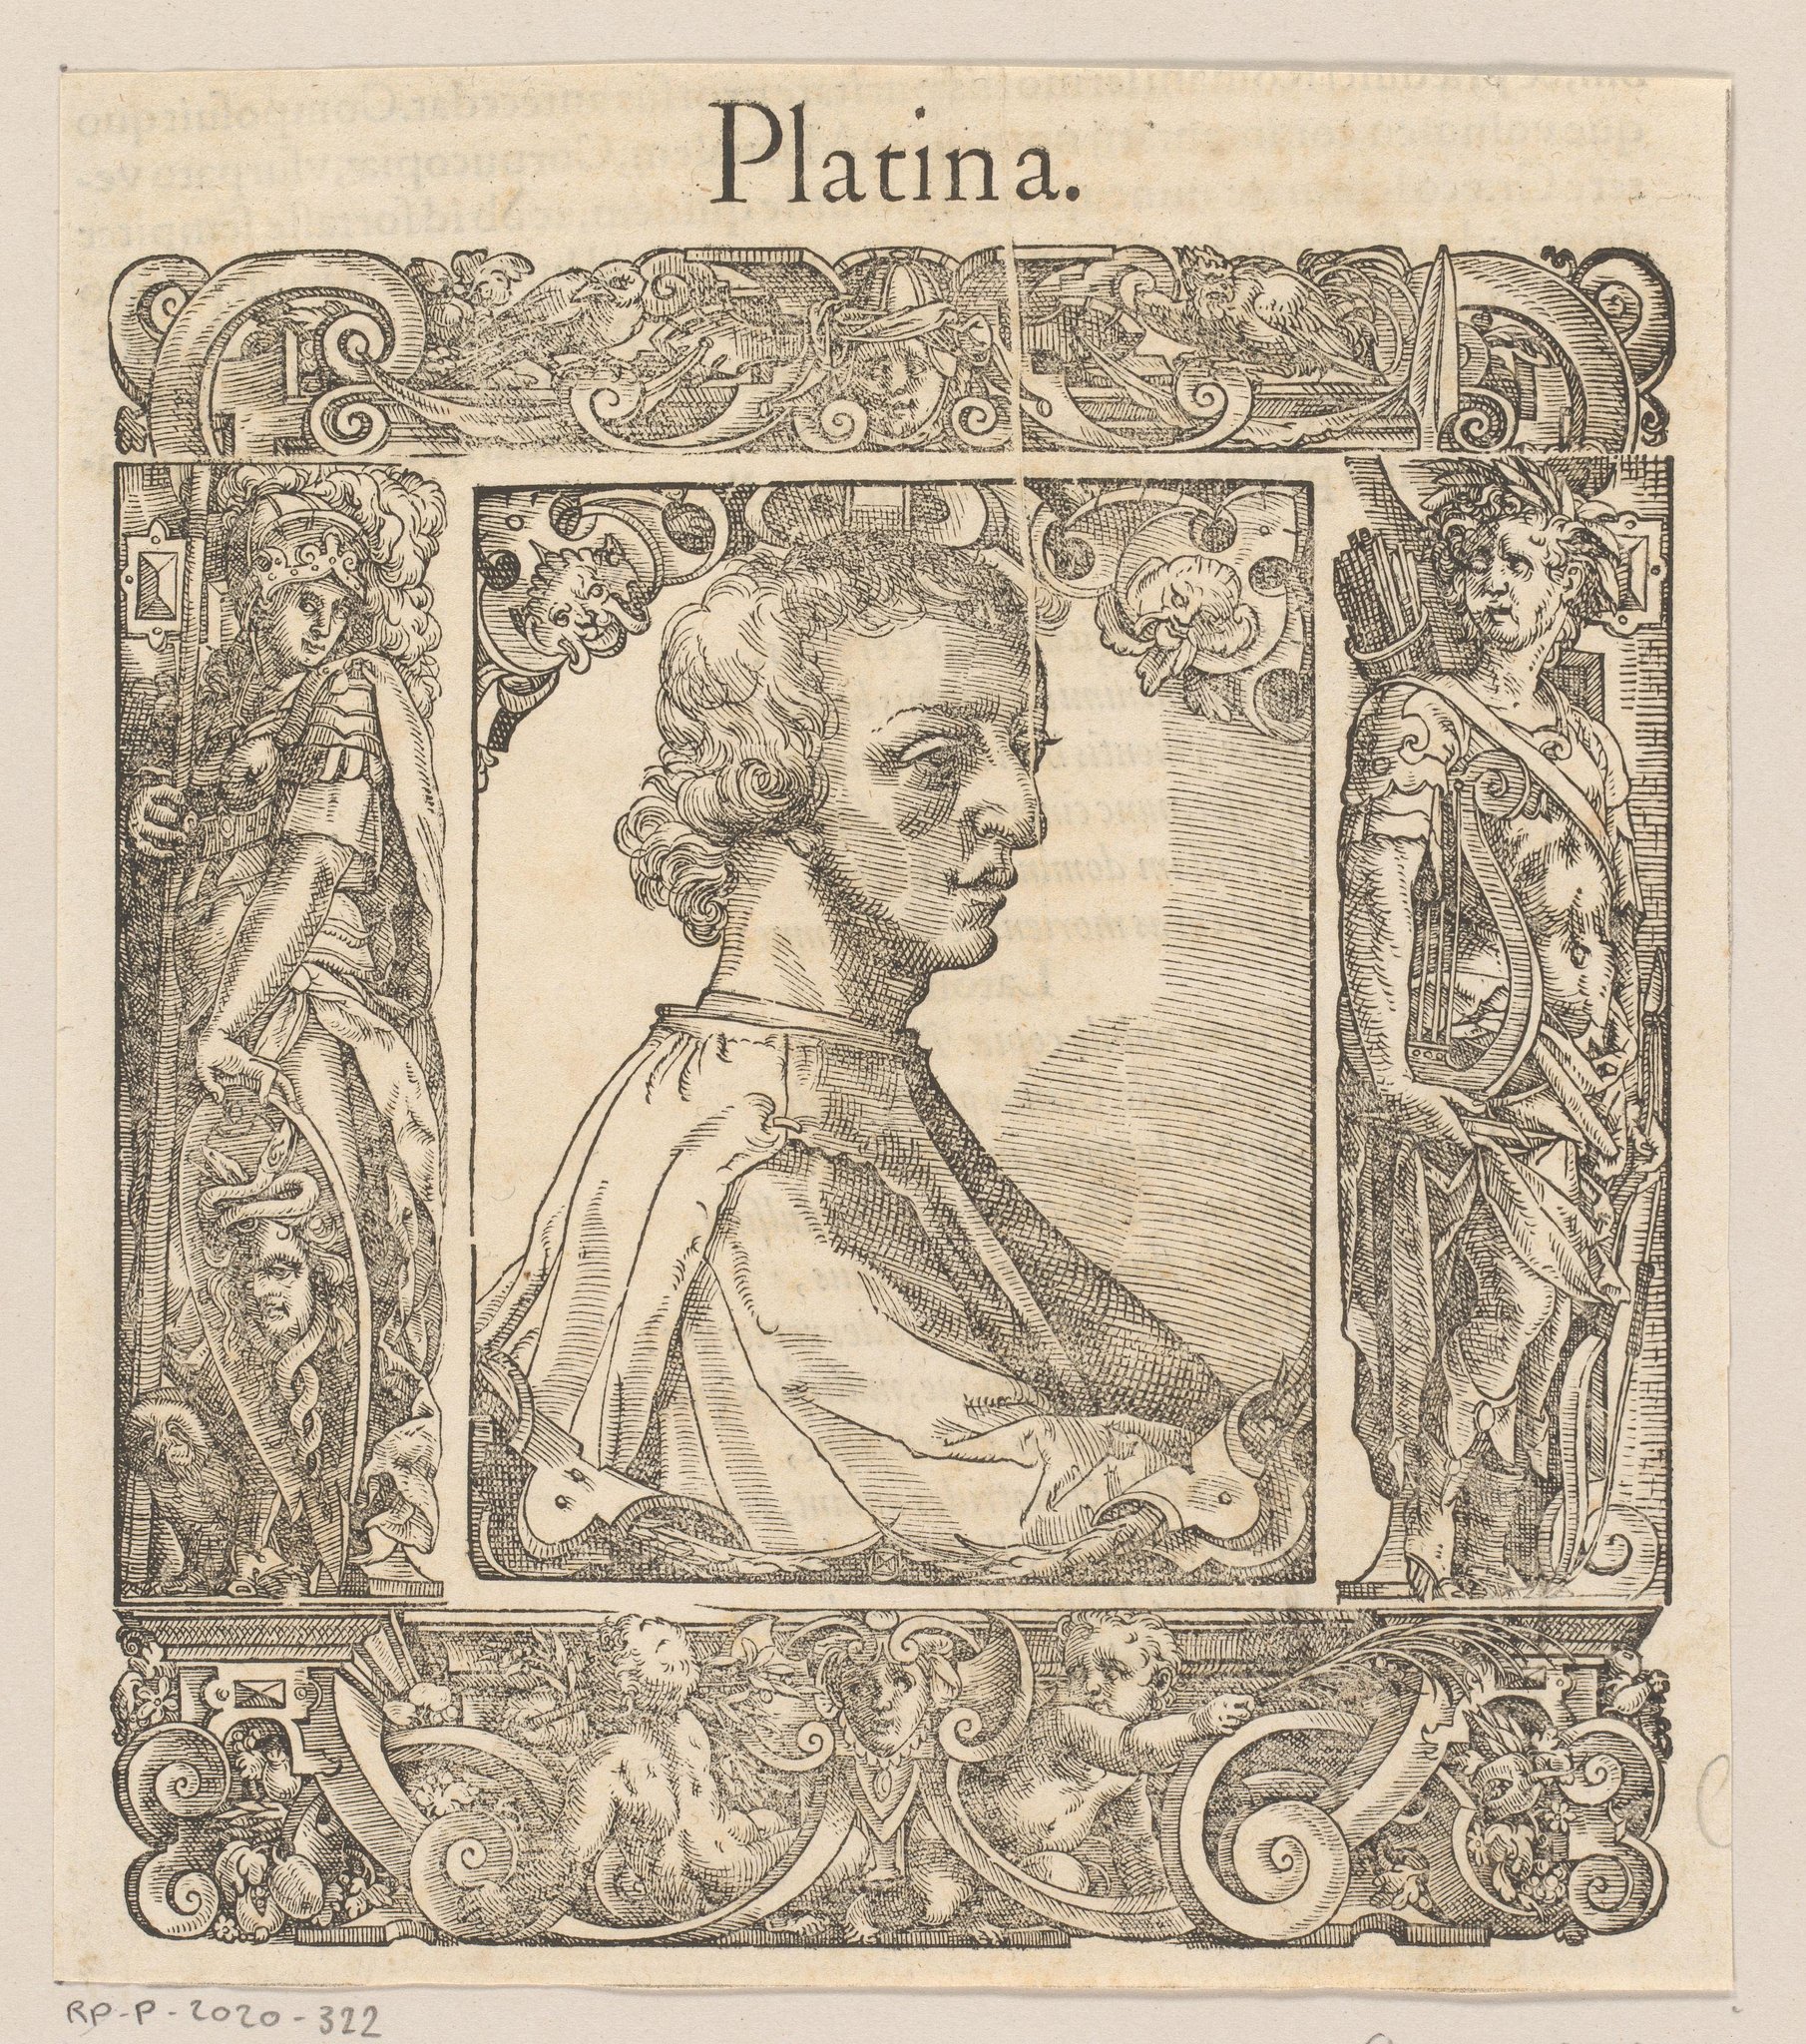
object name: print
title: Portret van Bartolomeo Platina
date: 1577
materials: paper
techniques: letterpress printing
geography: basel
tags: historical persons, portrait of a writer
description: Prent uit: Giovio, Paolo. Elogia virorum literis illustrium, quotquot (...). Bazel: Peter Perna, 1577, p. 34. Prent ook gebruikt in latere publicaties.